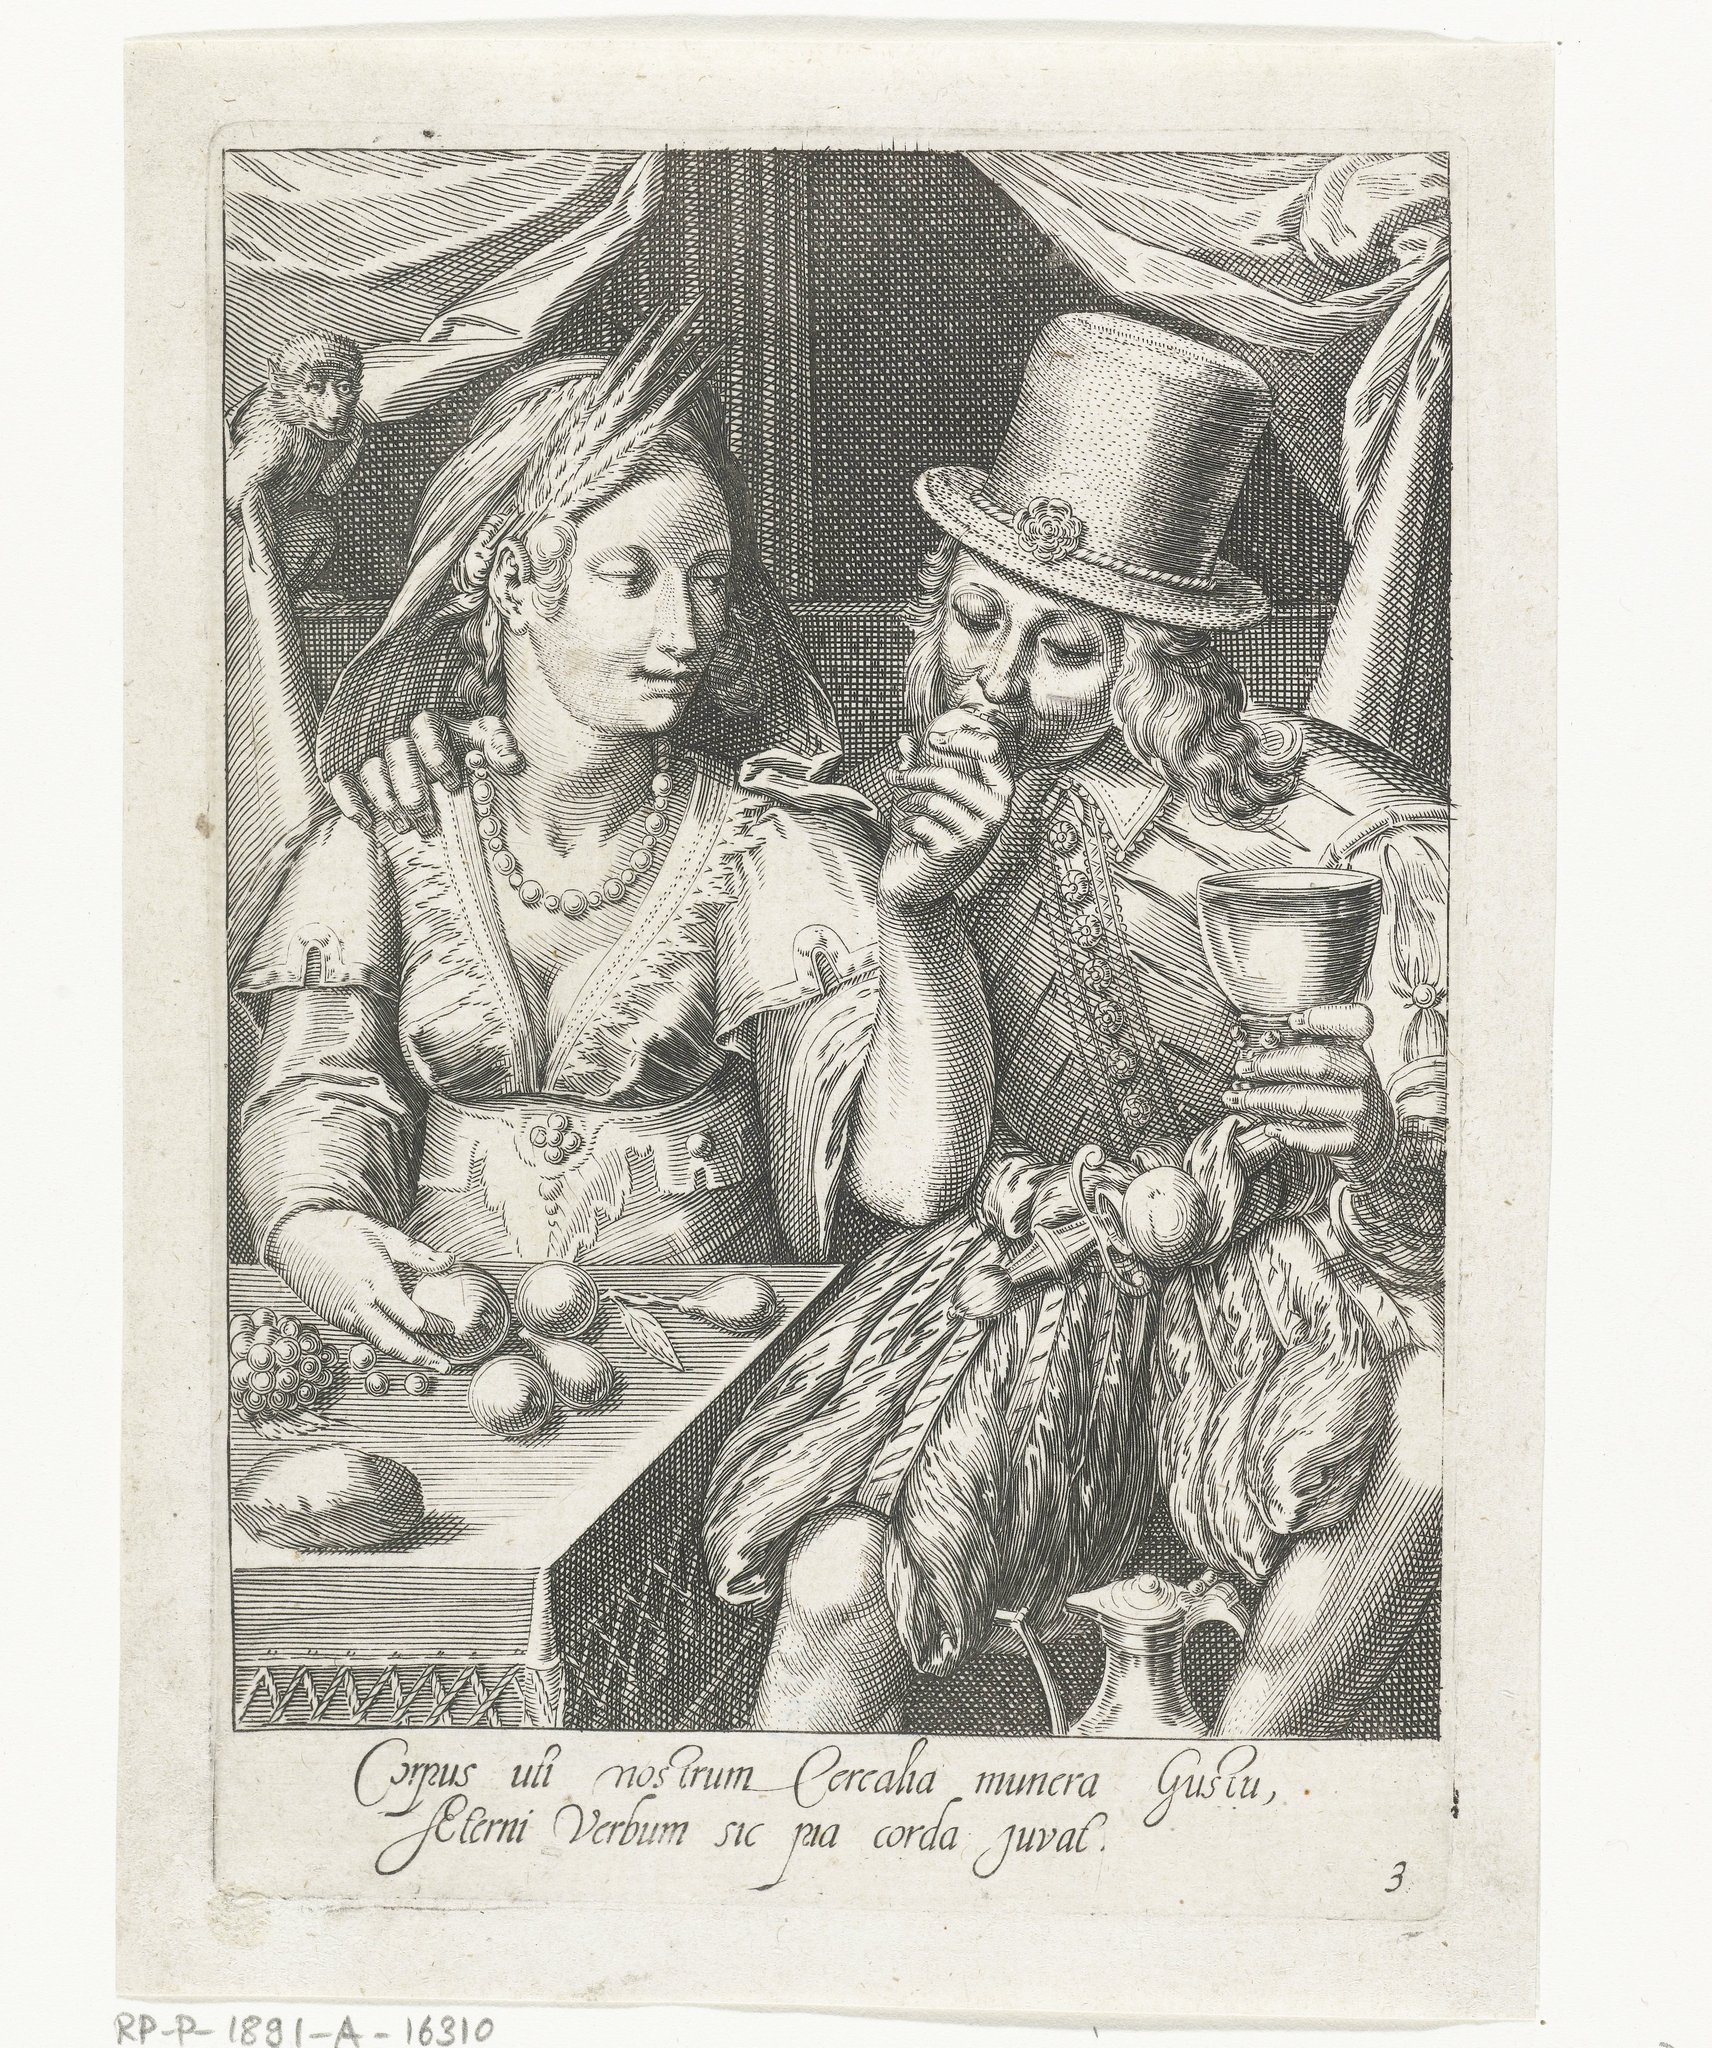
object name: print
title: De vijf zintuigen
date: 1663-1693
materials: paper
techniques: engraving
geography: amsterdam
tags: taste, tasting (one of the five senses)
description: Een jonge vrouw laat een jonge man proeven van de vruchten die ze voor zich op tafel neer heeft gelegd. Beiden zijn goed gekleed en de man houdt een roemer in zijn hand Op de achtergrond zit een aapje in de gordijnen. Prent uit een serie van vijf prenten met voorstellingen van de zintuigen.